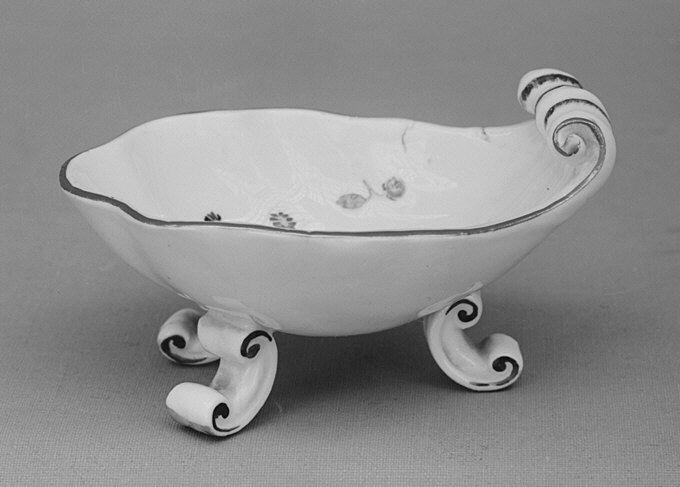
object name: saltcellar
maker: höchst manufactory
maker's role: manufactory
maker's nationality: german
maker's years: 1746-1796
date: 1770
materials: hard paste porcelain